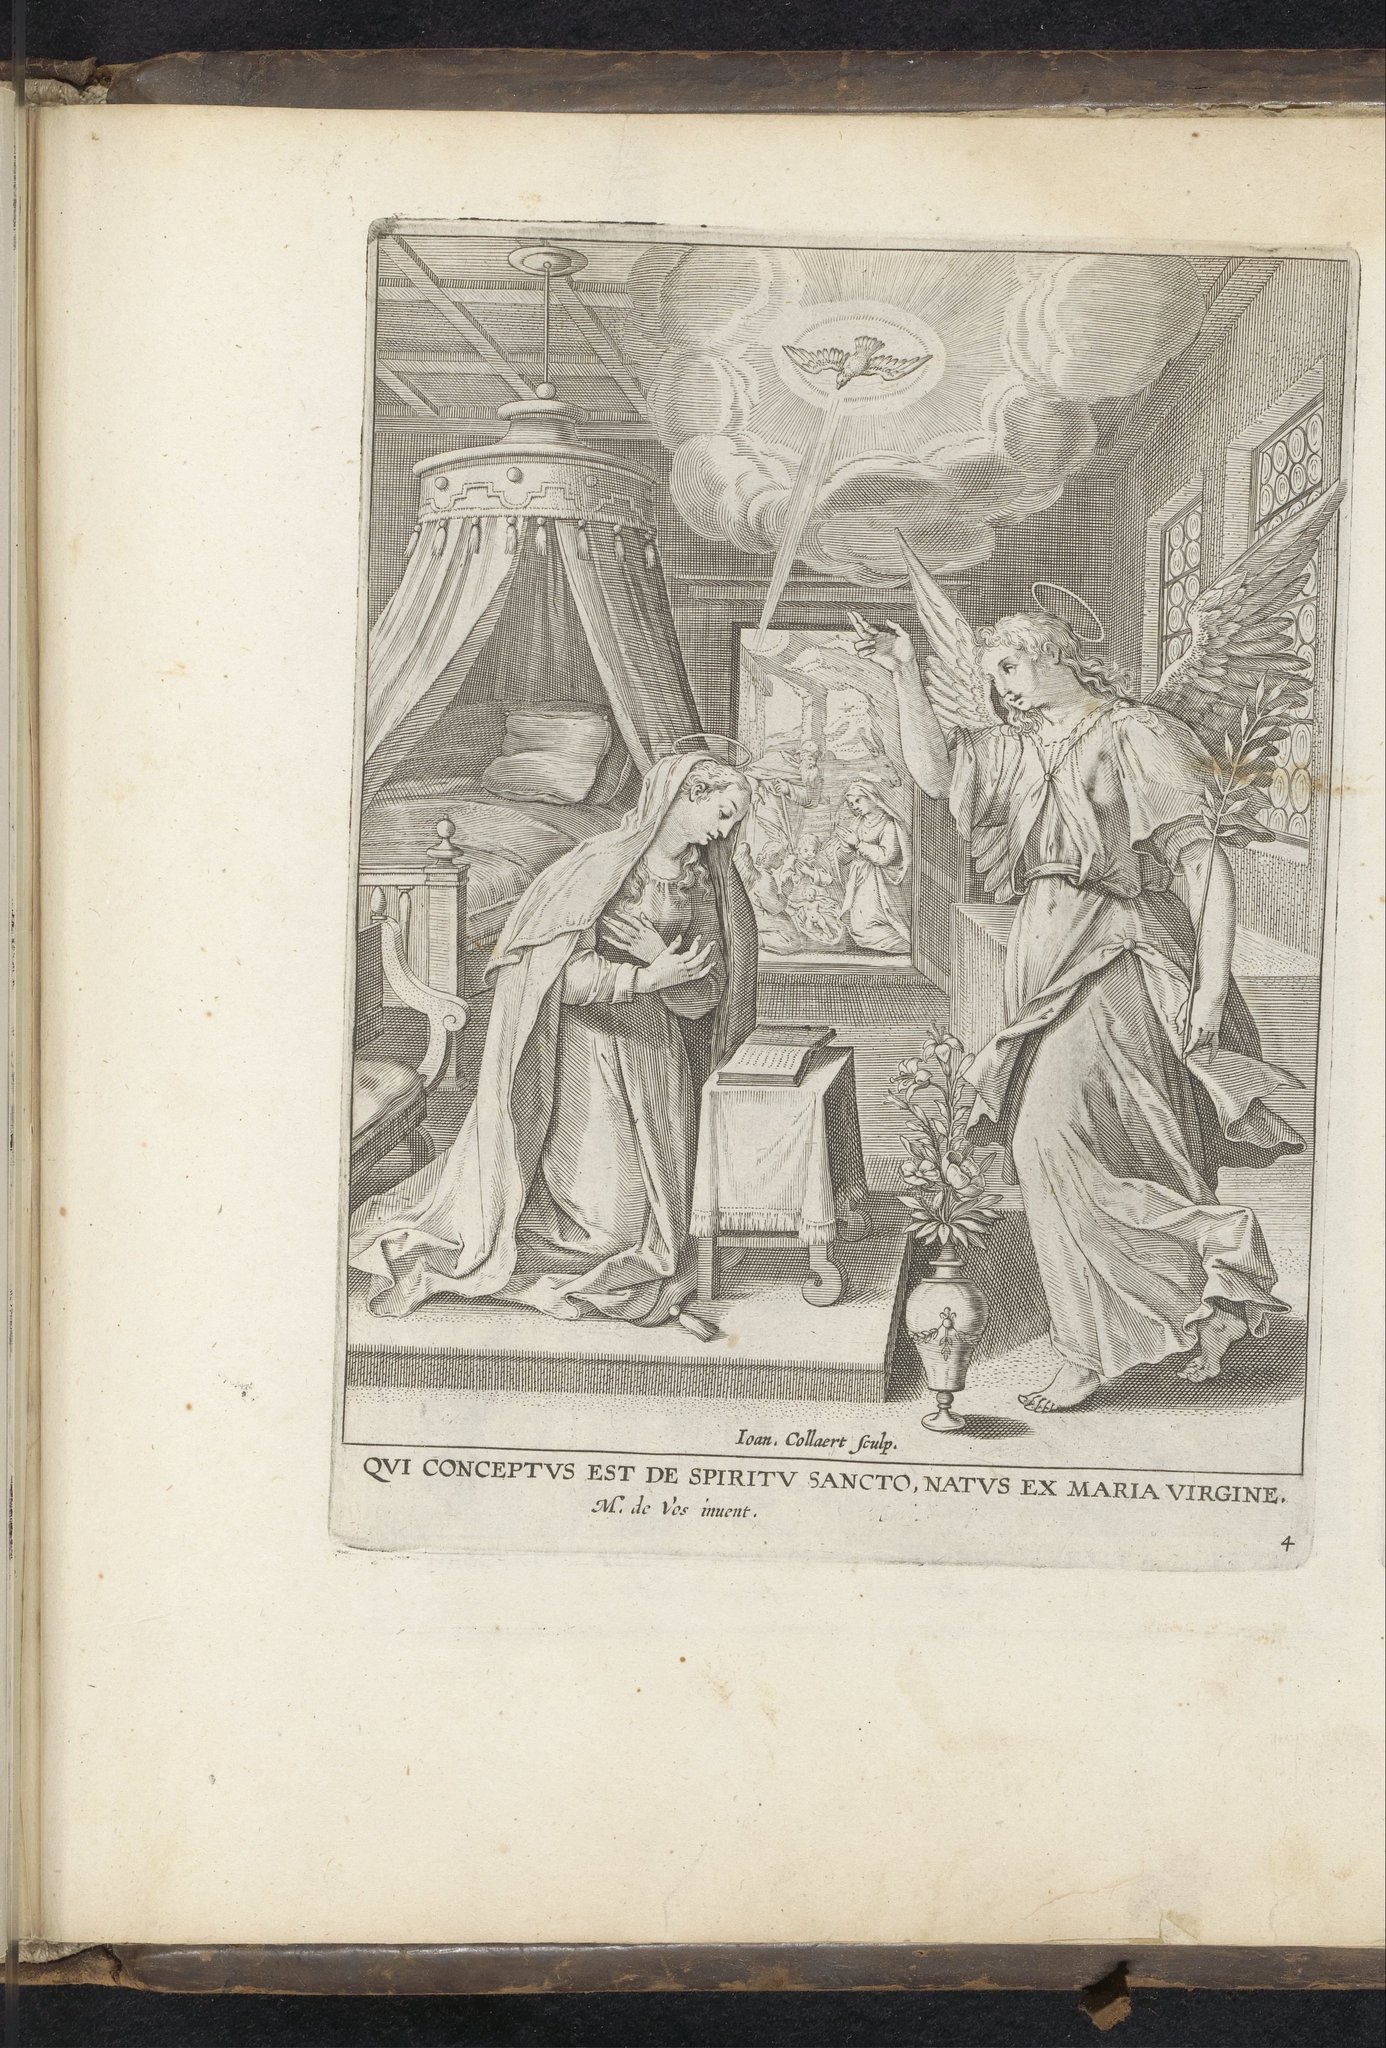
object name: print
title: Apostolische geloofsbelijdenis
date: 1570-1618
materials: paper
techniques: engraving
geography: alkmaar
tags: the annunciation: mary kneeling - aa - mary to the left, the angel to the right, 'qui conceptus est de spirito sancto, natus est ex maria virgine' ~ articles of faith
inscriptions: number: ‘201’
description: Illustratie van het derde geloofsartikel ([Christus] die ontvangen is van de heilige Geest, geboren uit de maagd Maria) van de apostolische geloofsbelijdenis. De engel Gabriël kondigt aan Maria aan dat ze zwanger zal worden. Maria zit geknield bij een lessenaar, waarop een opengeslagen boek ligt. De Heilige Geest daalt als een duif neer. Deze prent maakt deel uit van een album.